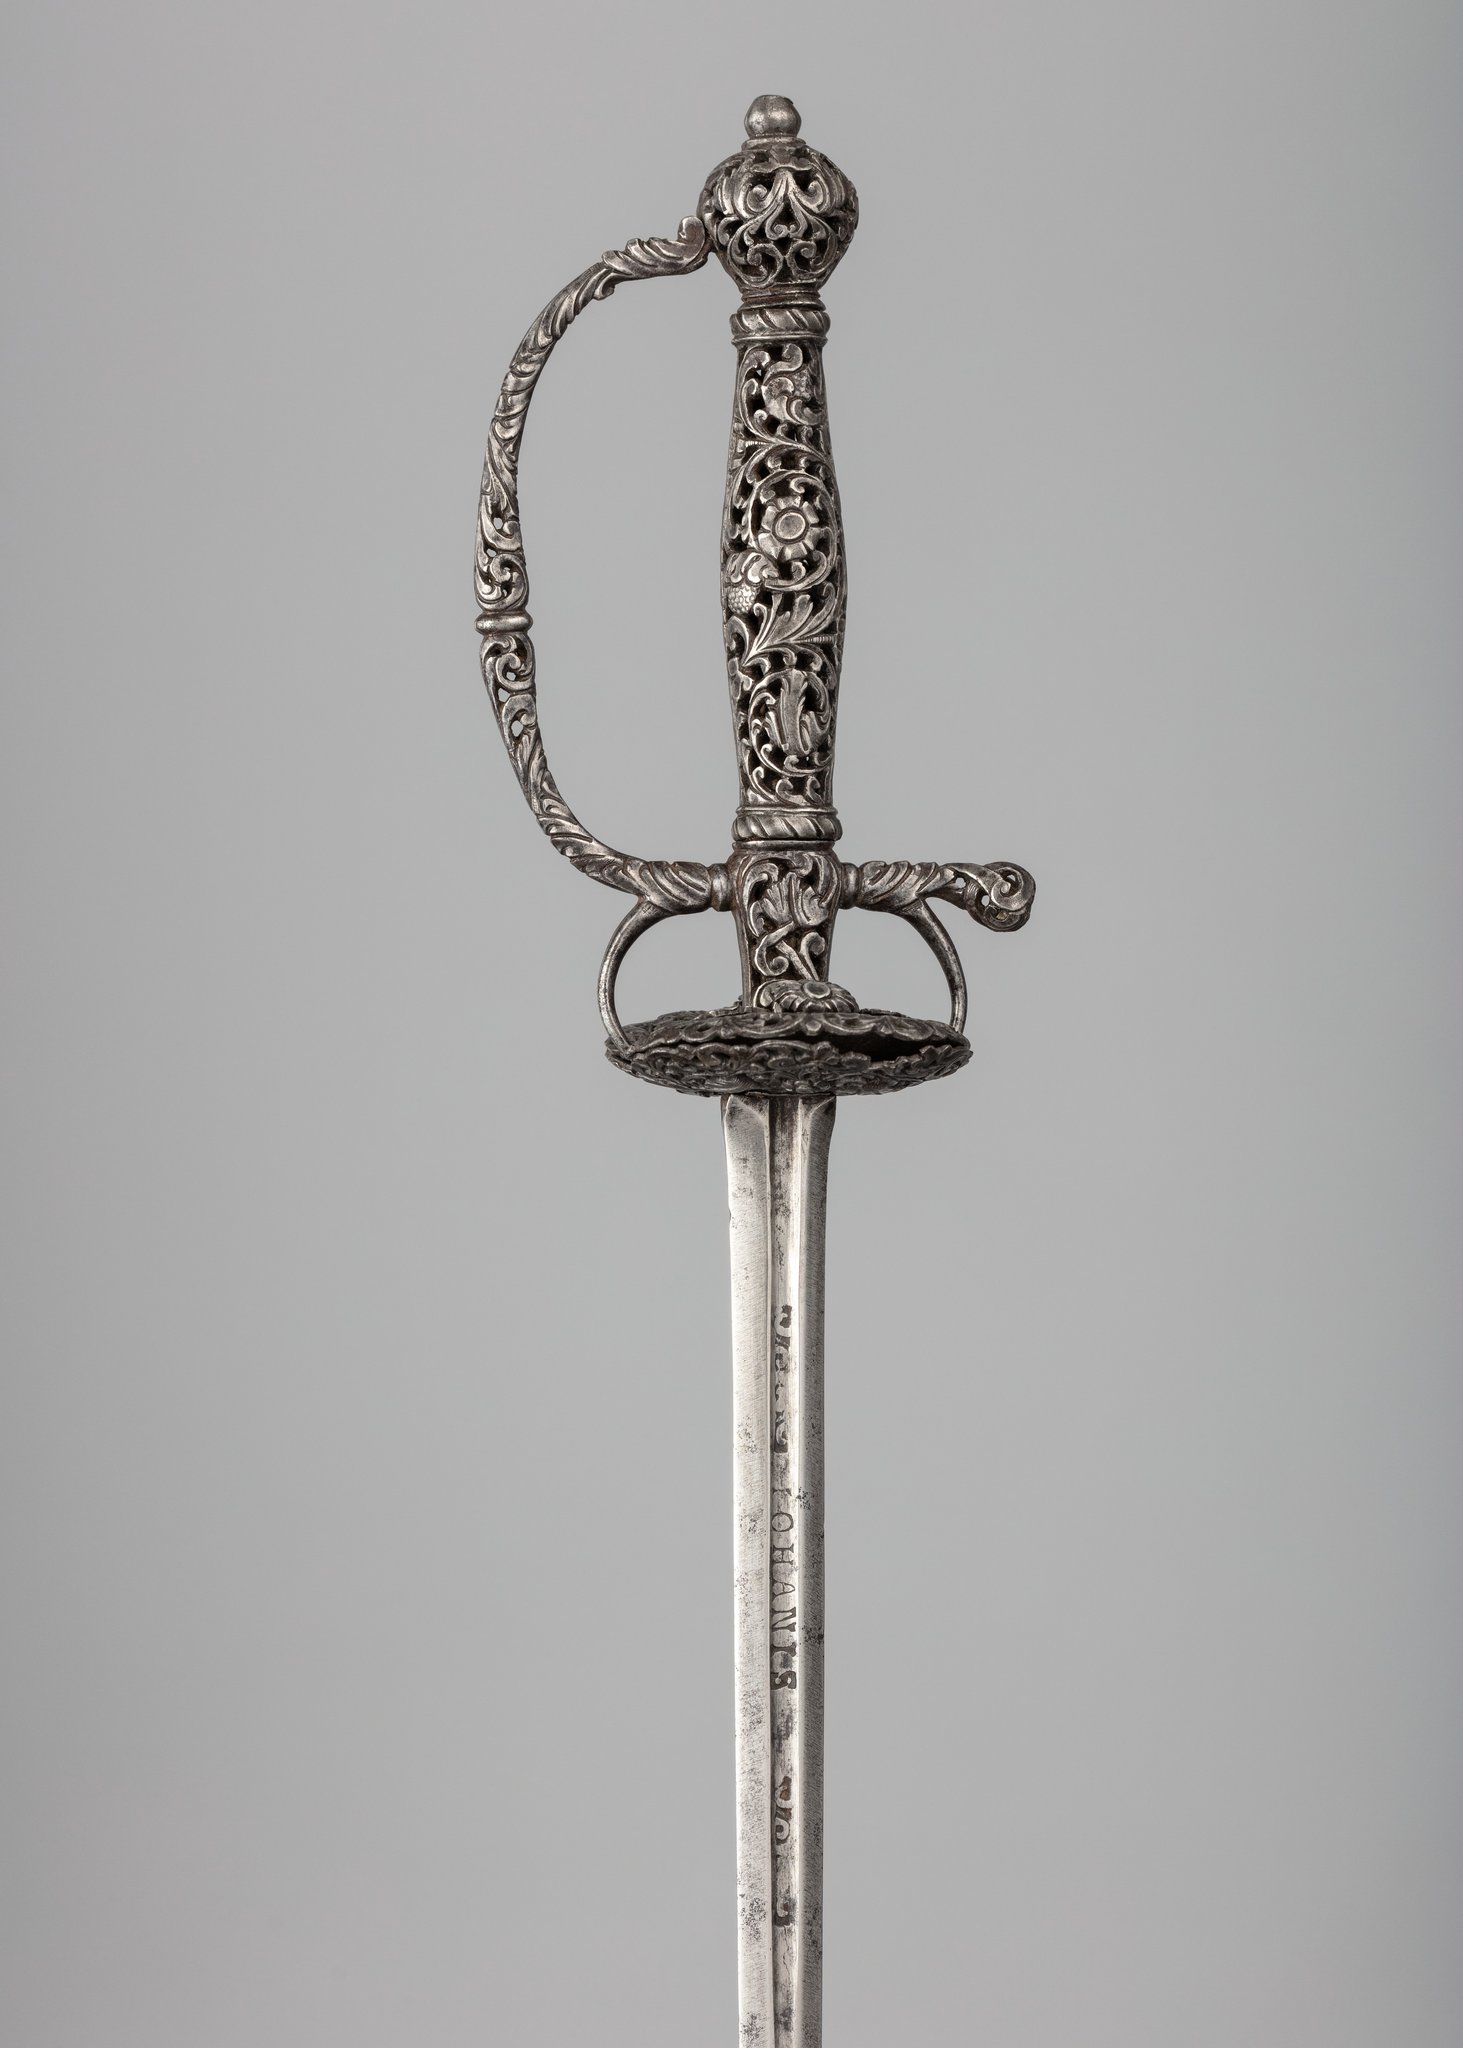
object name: page's sword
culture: german or italian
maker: johann tetsche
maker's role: artist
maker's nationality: german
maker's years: 1700-1742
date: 1700-1742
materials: steel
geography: italy